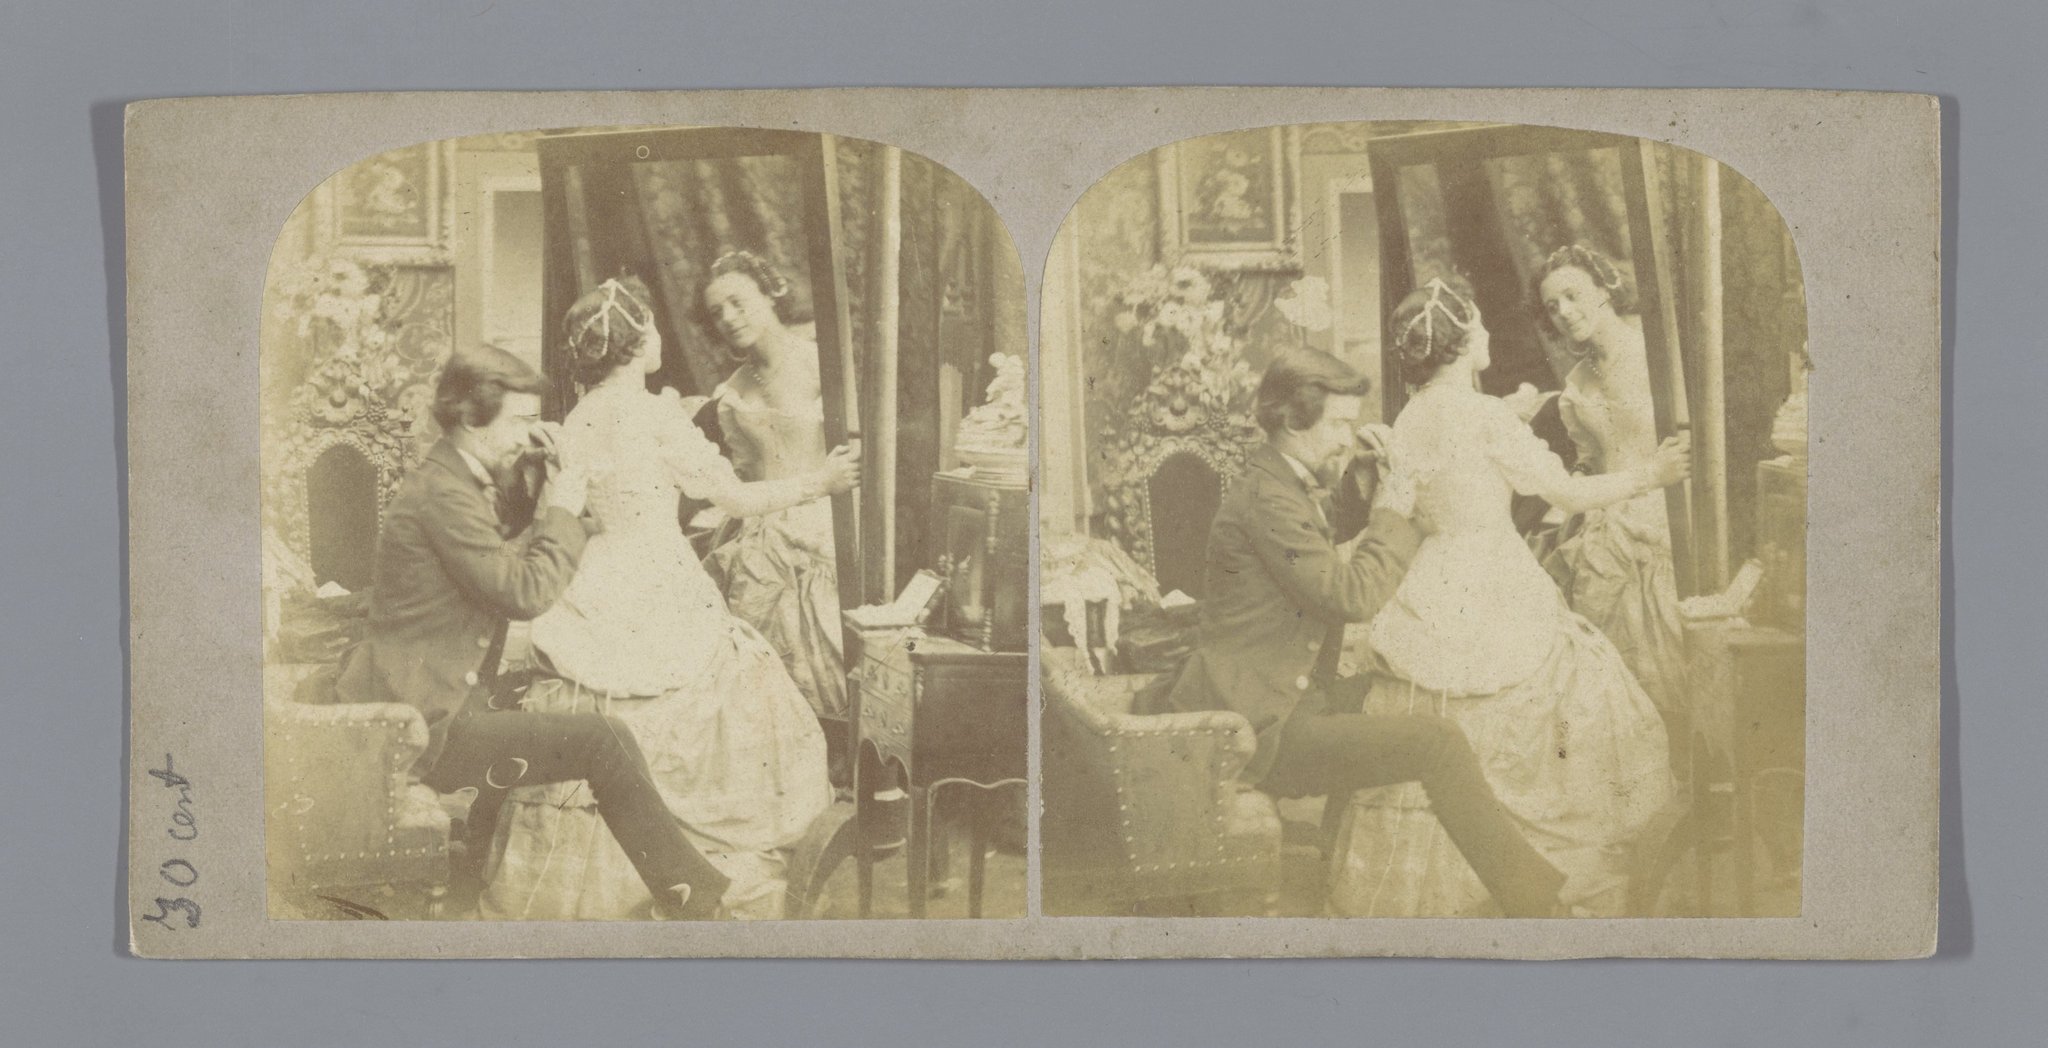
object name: stereograph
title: Man knoopt het korset van een vrouw voor een spiegel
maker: Anonymous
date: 1850-1880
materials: cardboard, photographic support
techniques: albumen print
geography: europe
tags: lacing up a corset, mirror, europe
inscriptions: number: ‘60.’, inscription: ‘30 cent’